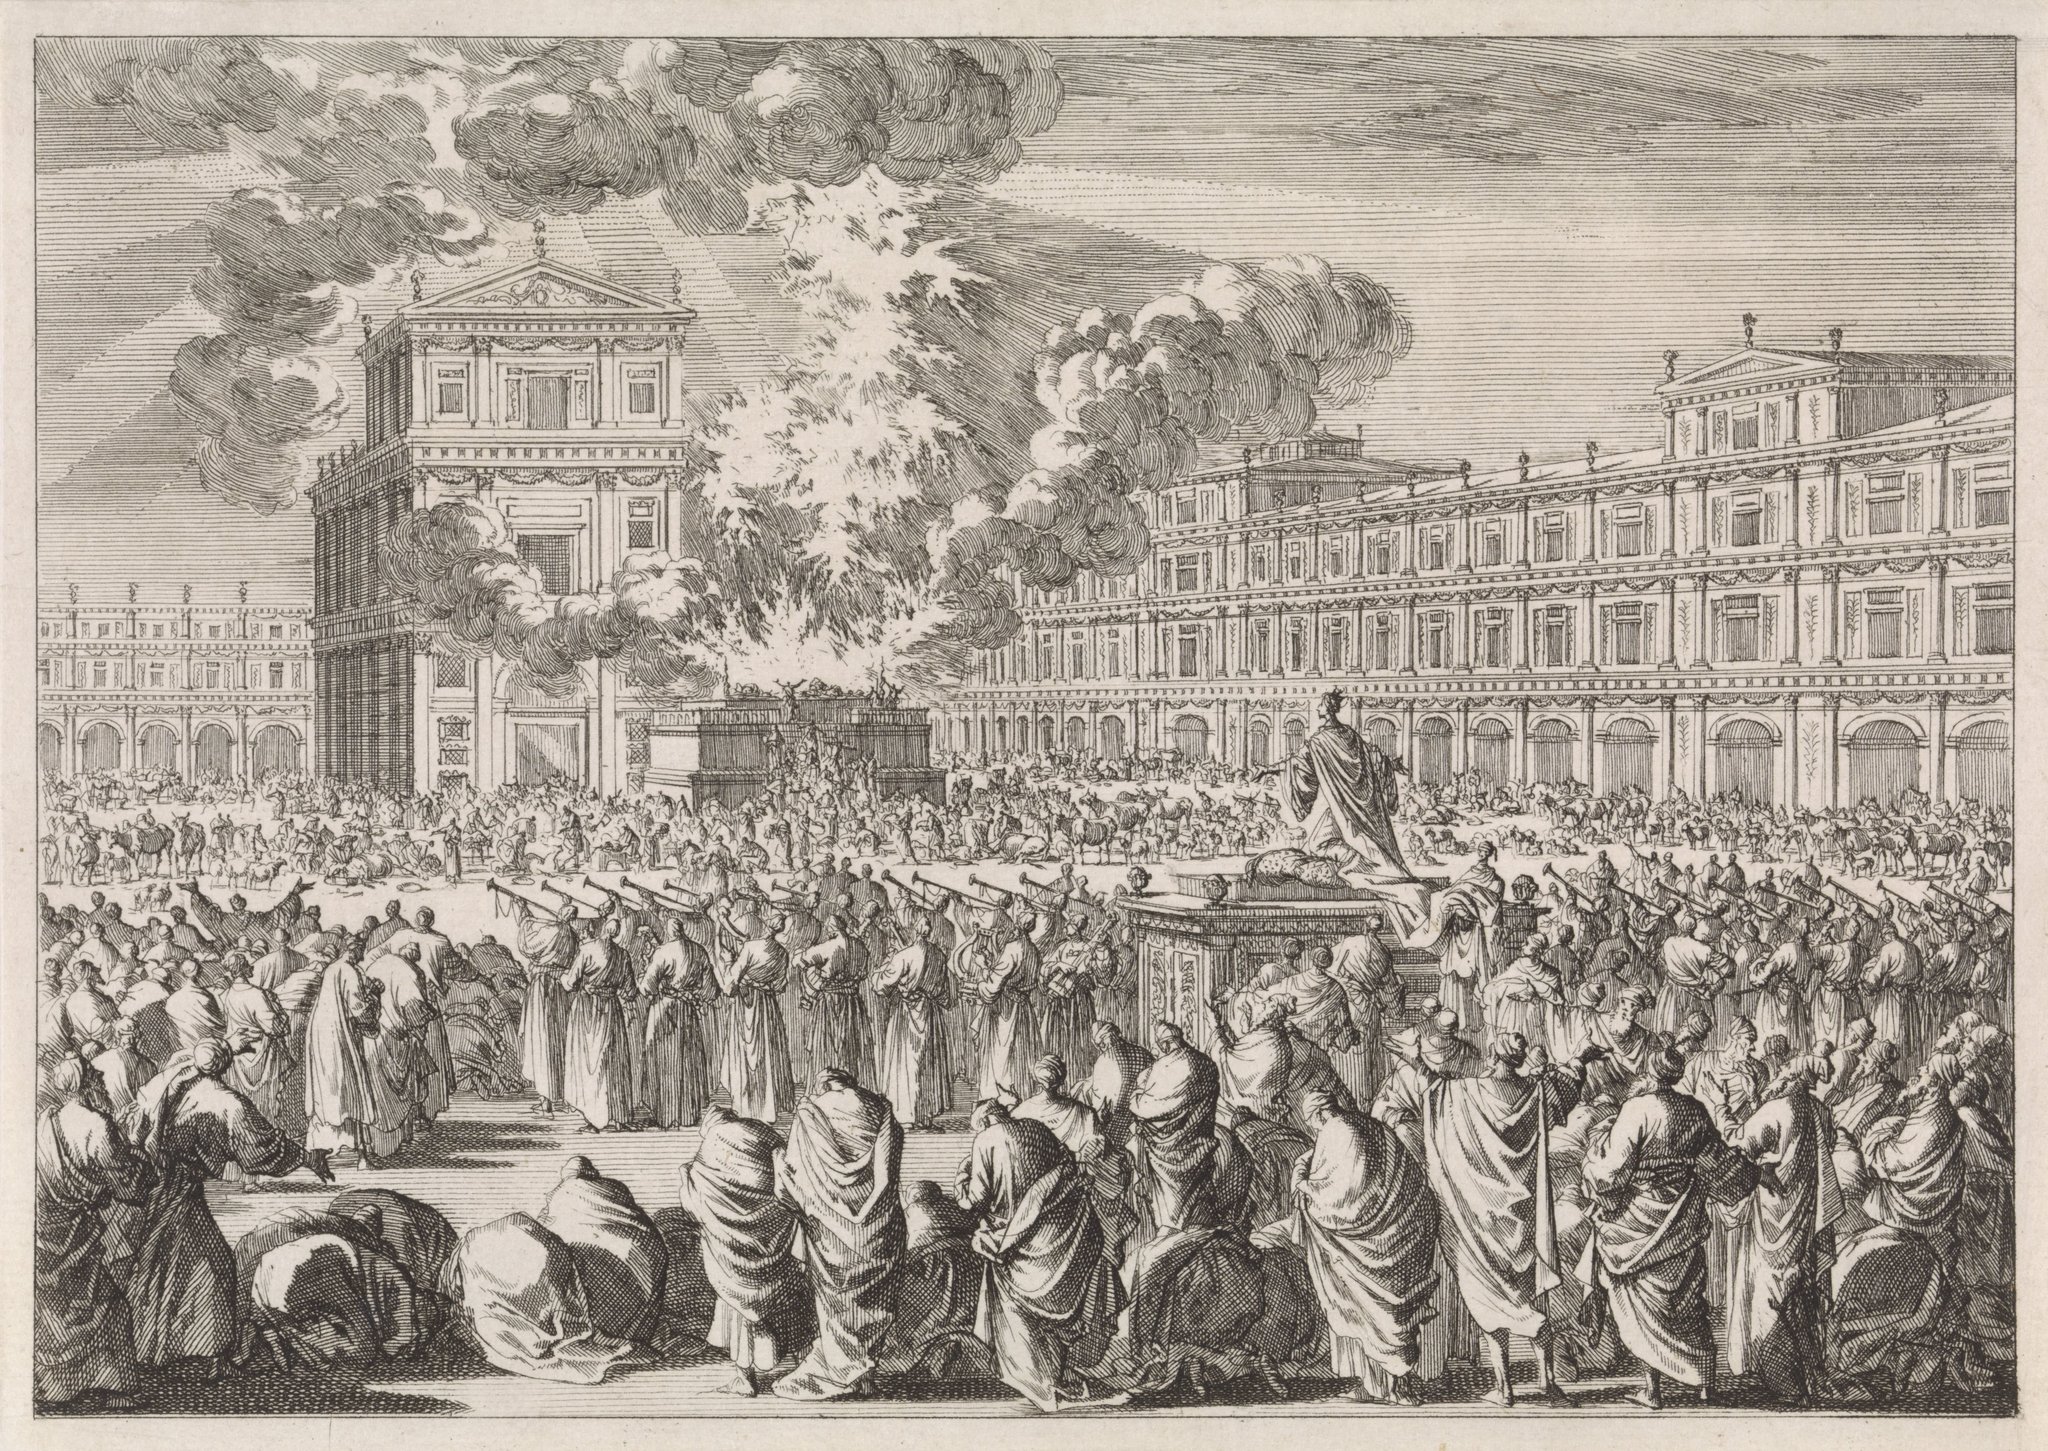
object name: print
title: Inwijding van de tempel van Salomo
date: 1700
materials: paper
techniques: etching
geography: amsterdam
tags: prayer of solomon; solomon kneels before the altar, the ark of the covenant is brought into the temple; a cloud fills the house of the lord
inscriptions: collector's mark: Lugt 2228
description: Op het plein voor de tempel van Salomo wordt de tempel met feestelijkheden ingewijd. Koning Salomo zit geknield op een verhoog. Op de achtergrond de tempel en een groot altaar waar offers worden gebracht. God verschijnt als een donkere wolk aan de hemel.